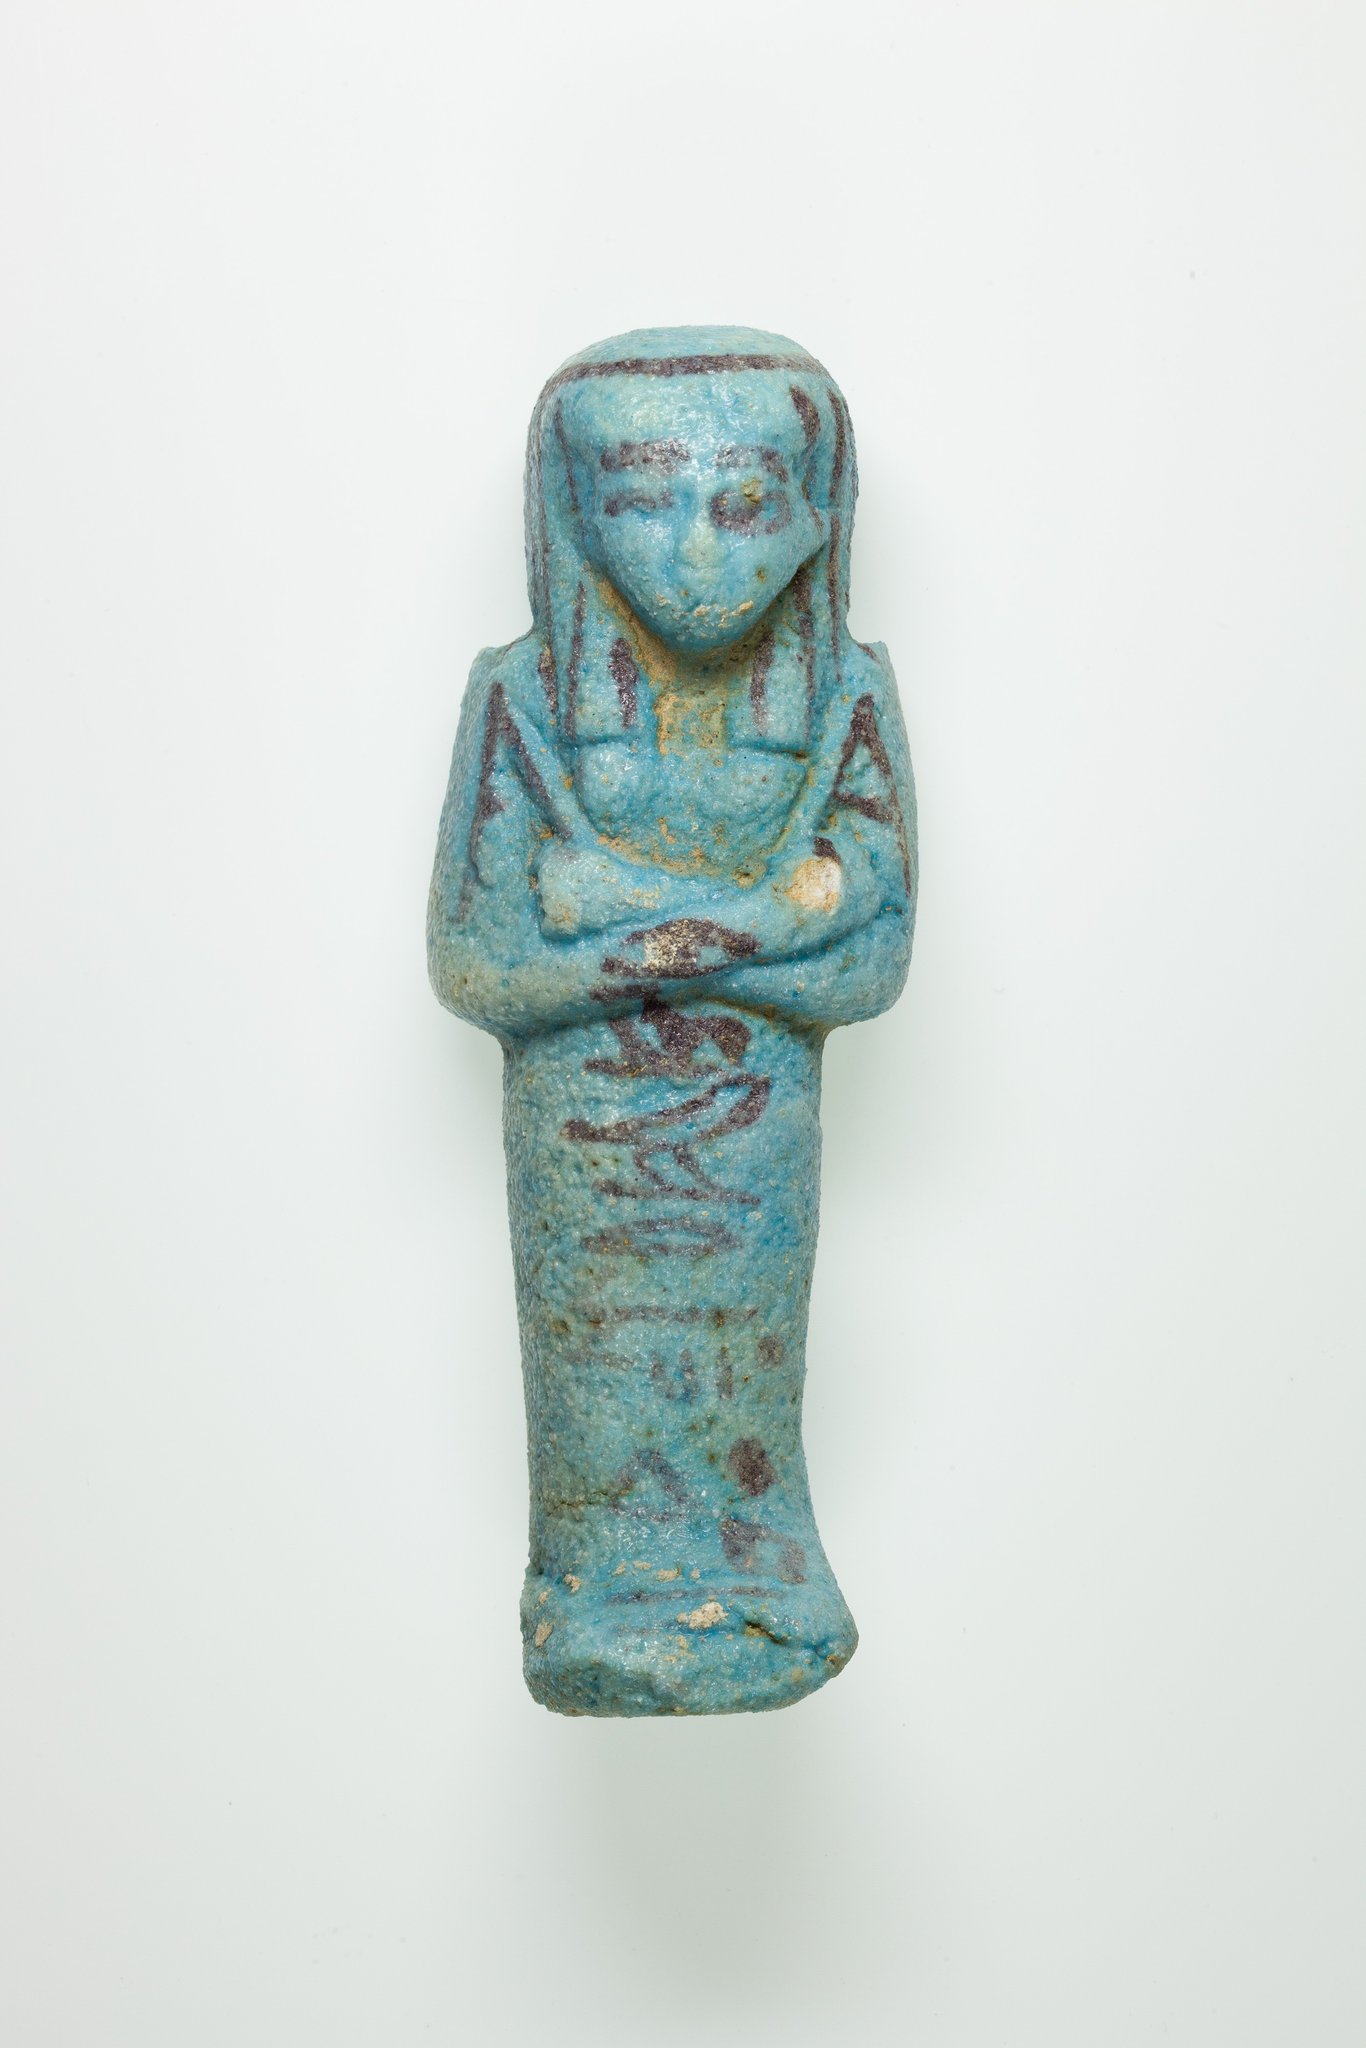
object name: worker shabti, henettawy c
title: Worker Shabti of Henettawy (C), Daughter of Isetemkheb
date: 990-970 BCE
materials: faience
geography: egypt